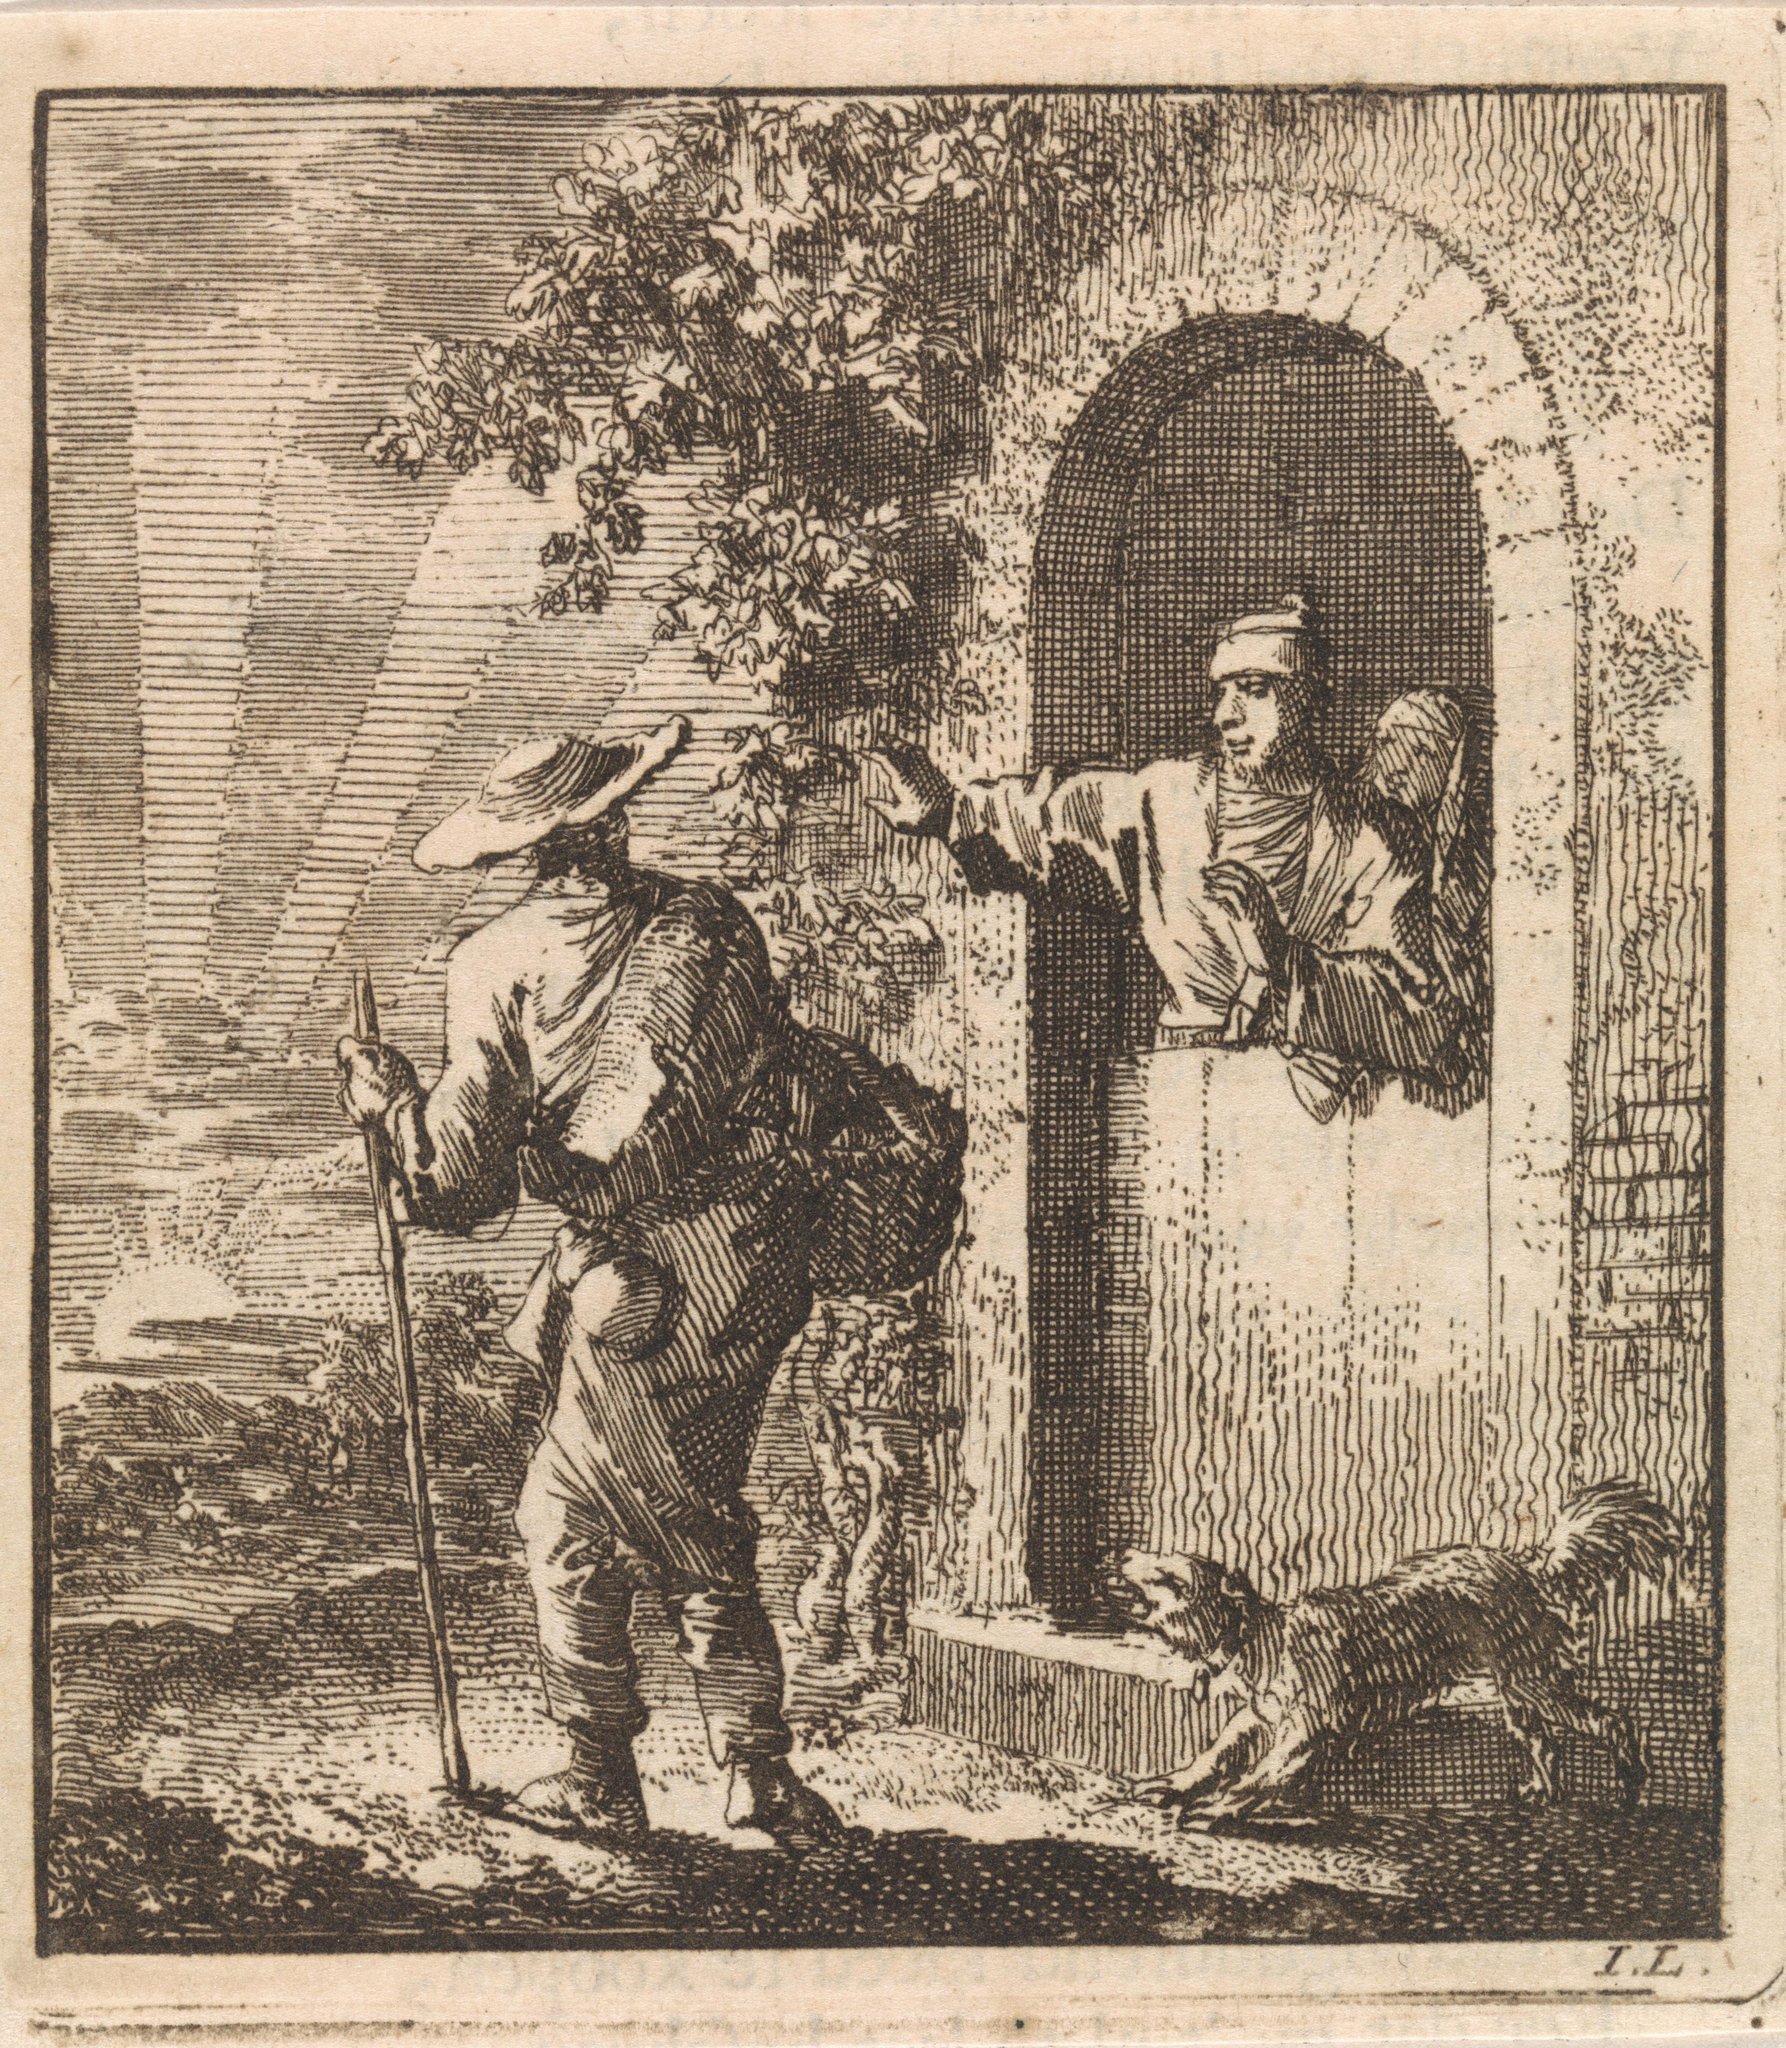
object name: book illustration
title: Man in een deuropening gebaart een vermoeide reiziger om door te gaan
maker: jan luyken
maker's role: draughtsman, print maker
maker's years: 1649-1712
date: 1711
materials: paper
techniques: etching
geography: amsterdam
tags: 'en route', traveller under way, dog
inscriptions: collector's mark: Lugt 2228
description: Illustratie voor: Spinniker, Adriaan. De werken en vergelding der barmhertigheid, en onbarmhertigheid. Amsterdam: Pieter Arentsz. II (wed.) en Cornelis van der Sys, 1711, p. 21.